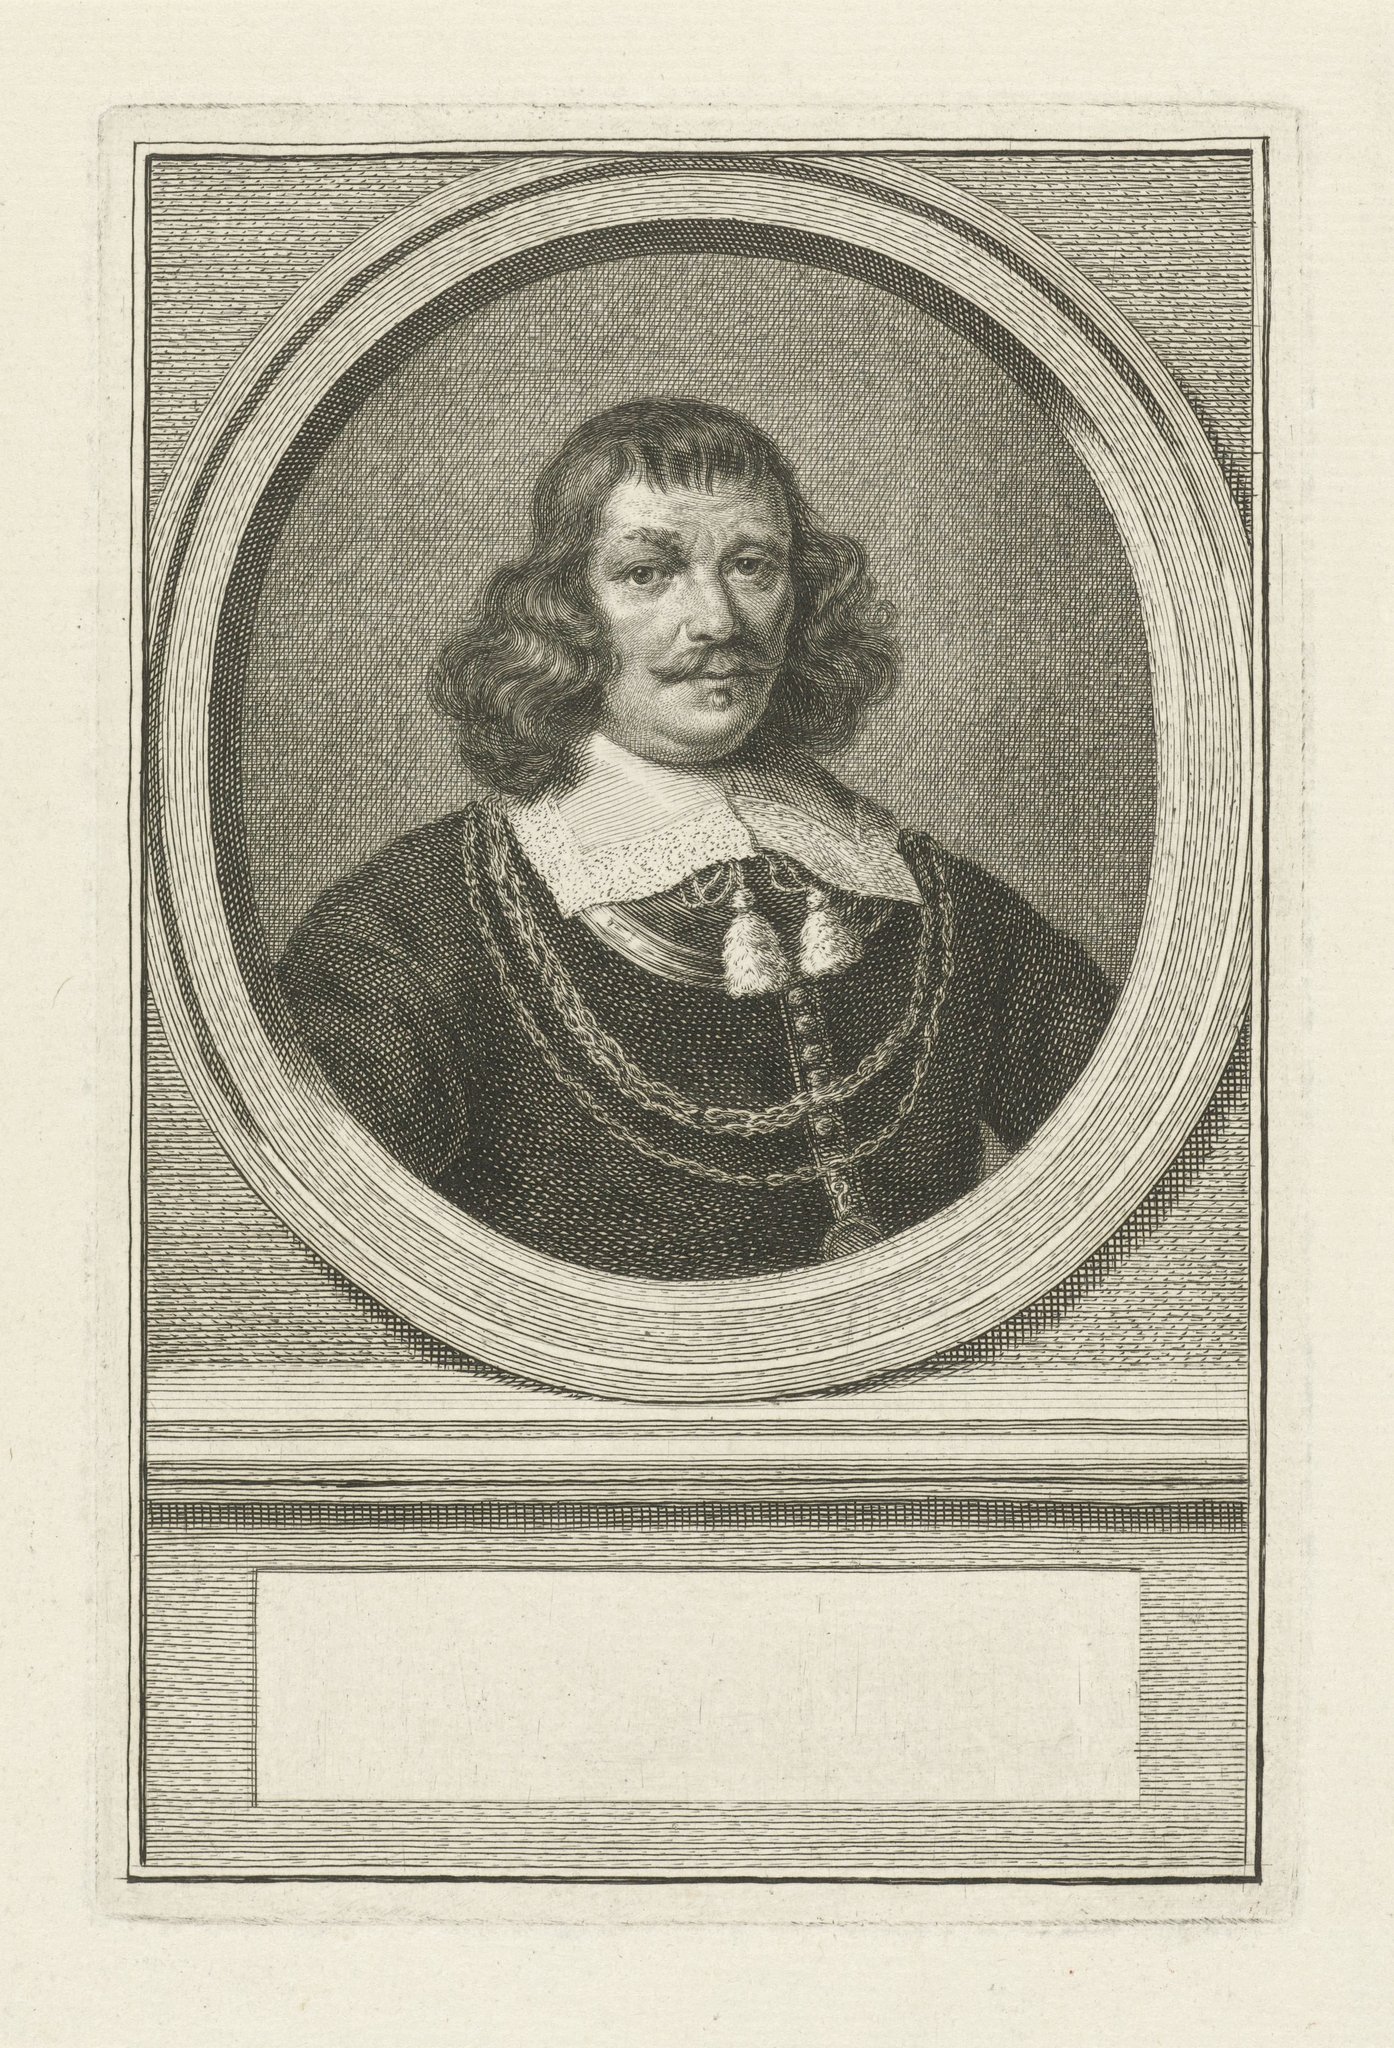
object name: print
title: Portret van Pieter Florisse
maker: jacob houbraken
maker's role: draughtsman, print maker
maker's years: 1698-1780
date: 1747-1759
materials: paper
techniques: engraving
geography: amsterdam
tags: sont, pieter florisse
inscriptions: collector's mark: Lugt 240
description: Proefdruk van de prent gebruikt in: Jan Wagenaar, Vaderlandsche historie, vervattende de geschiedenissen der nu Vereenigde Nederlanden, inzonderheid die van Holland (...), 21 delen. Amsterdam, Johannes Allart, 1790-96.